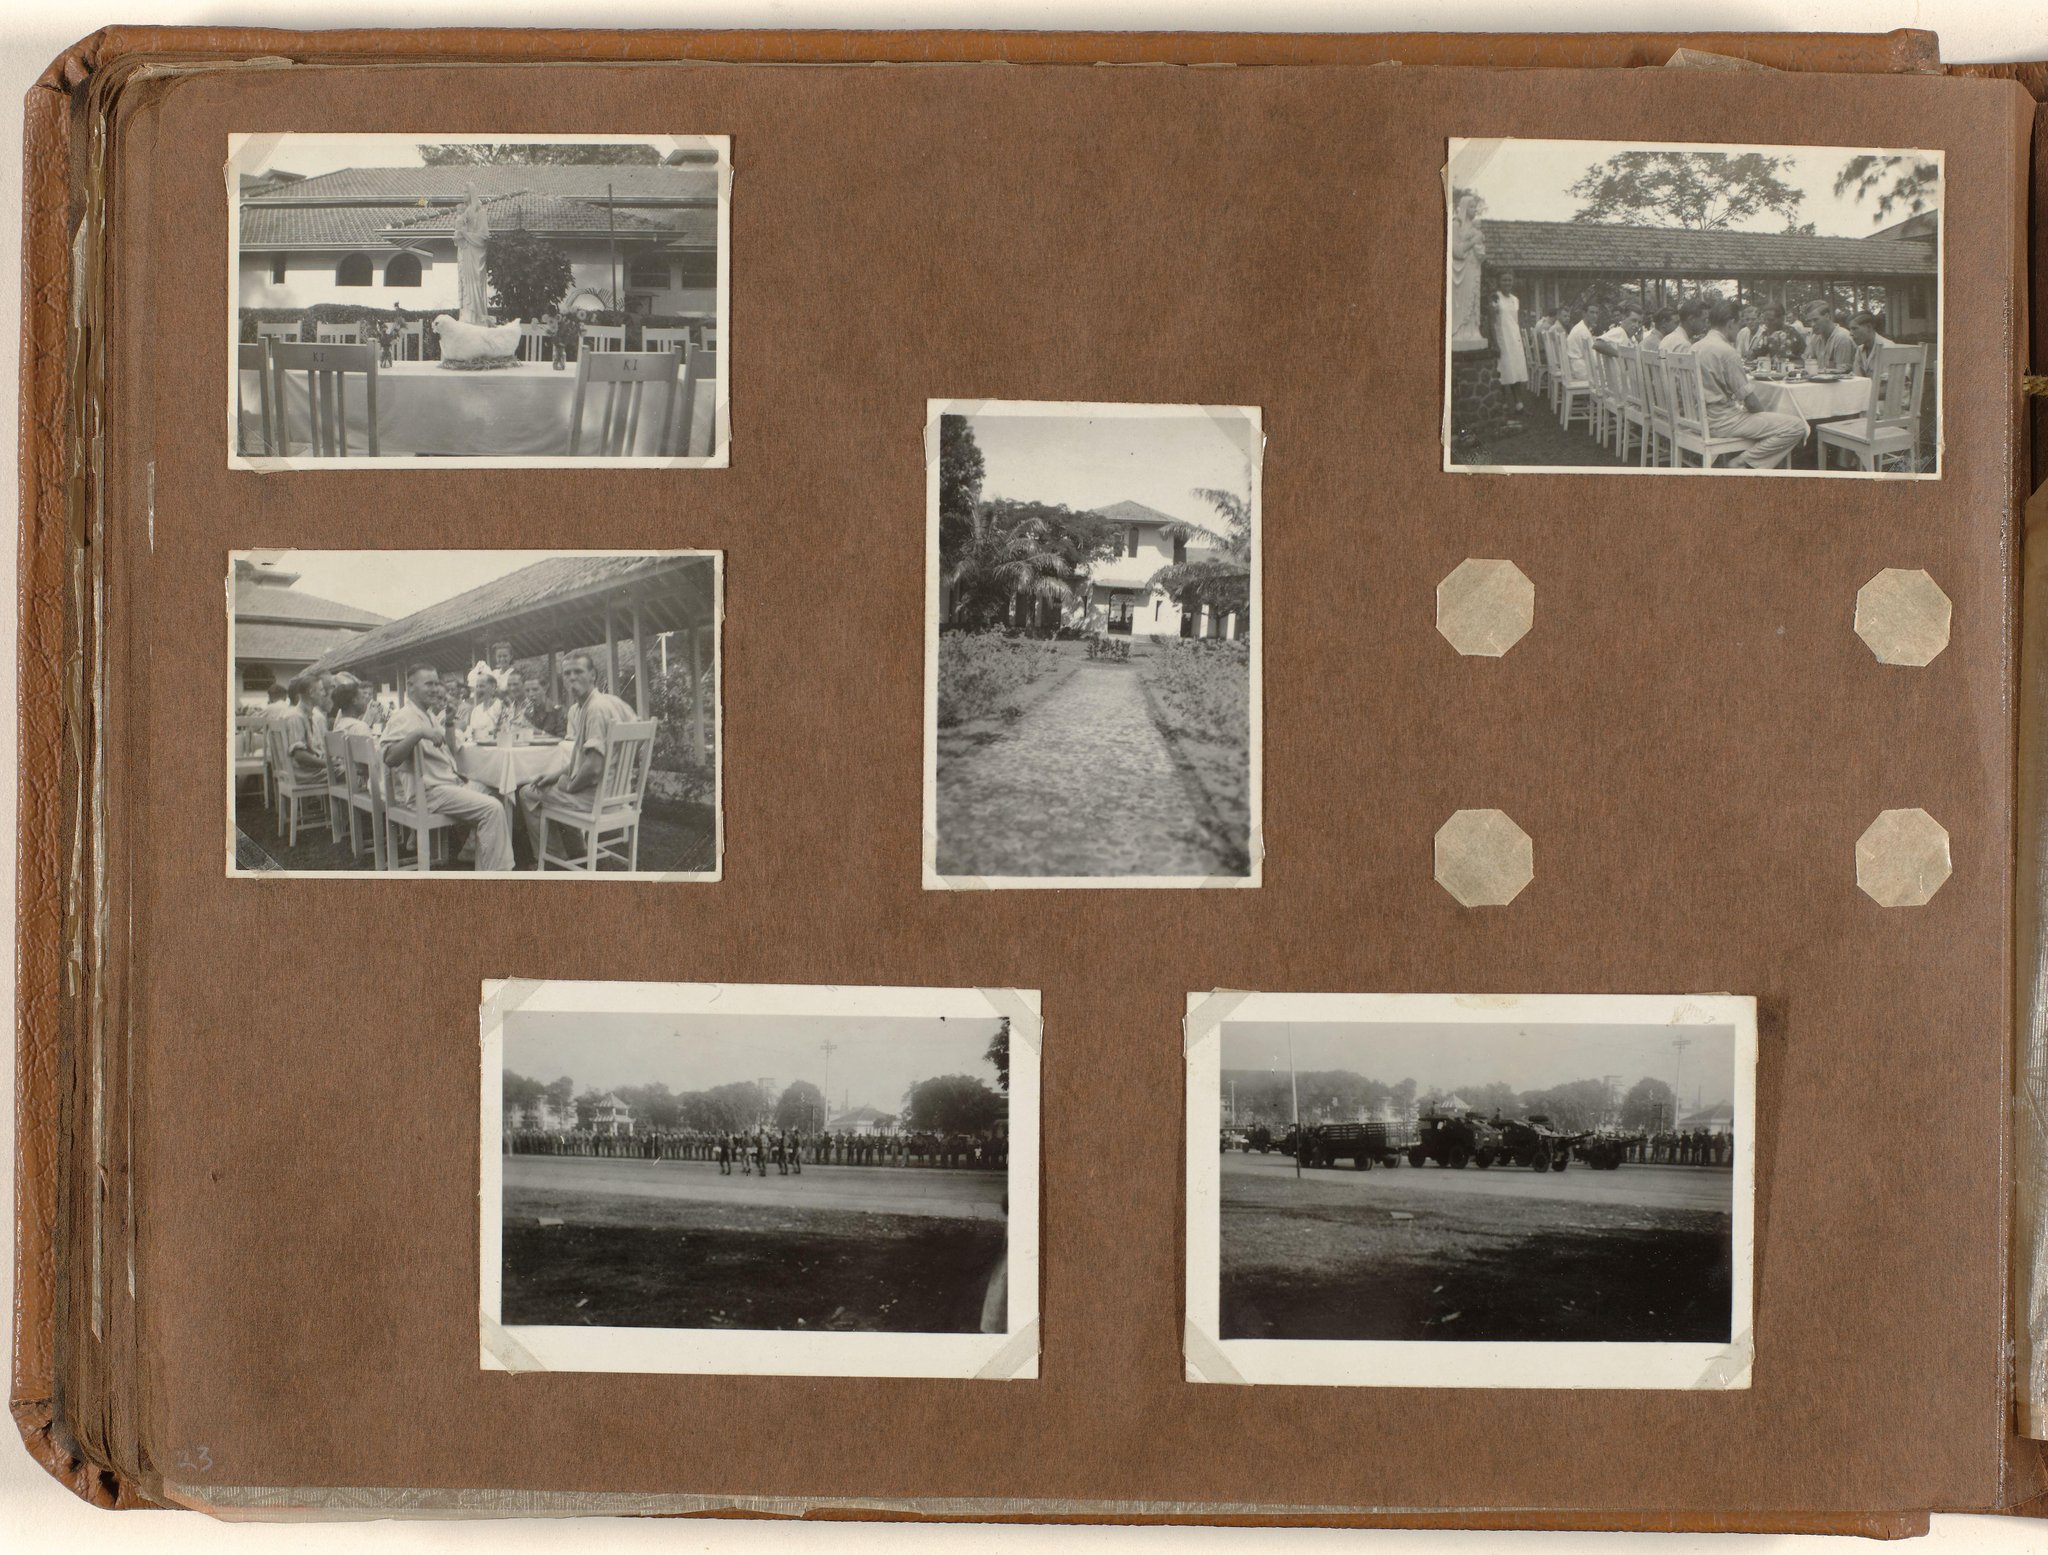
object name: photograph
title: Paasviering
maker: Anonymous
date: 1948-1949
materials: paper, photographic support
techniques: photography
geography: semarang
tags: the company, the unit, the troop ~ military service, the soldier off duty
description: Albumblad met zes foto's. Vier foto's van een paasontbijt met de militairen zittend aan tafels in vrijetijdskleding. Op tafel een kip. Een verpleegster bedient de militairen. Op één van de foto's steekt een soldaat rechts vooraan aan de tafel zijn tong uit. De stoelen hebben de inscriptie KI. Onderaan twee foto's van een militaire parade.